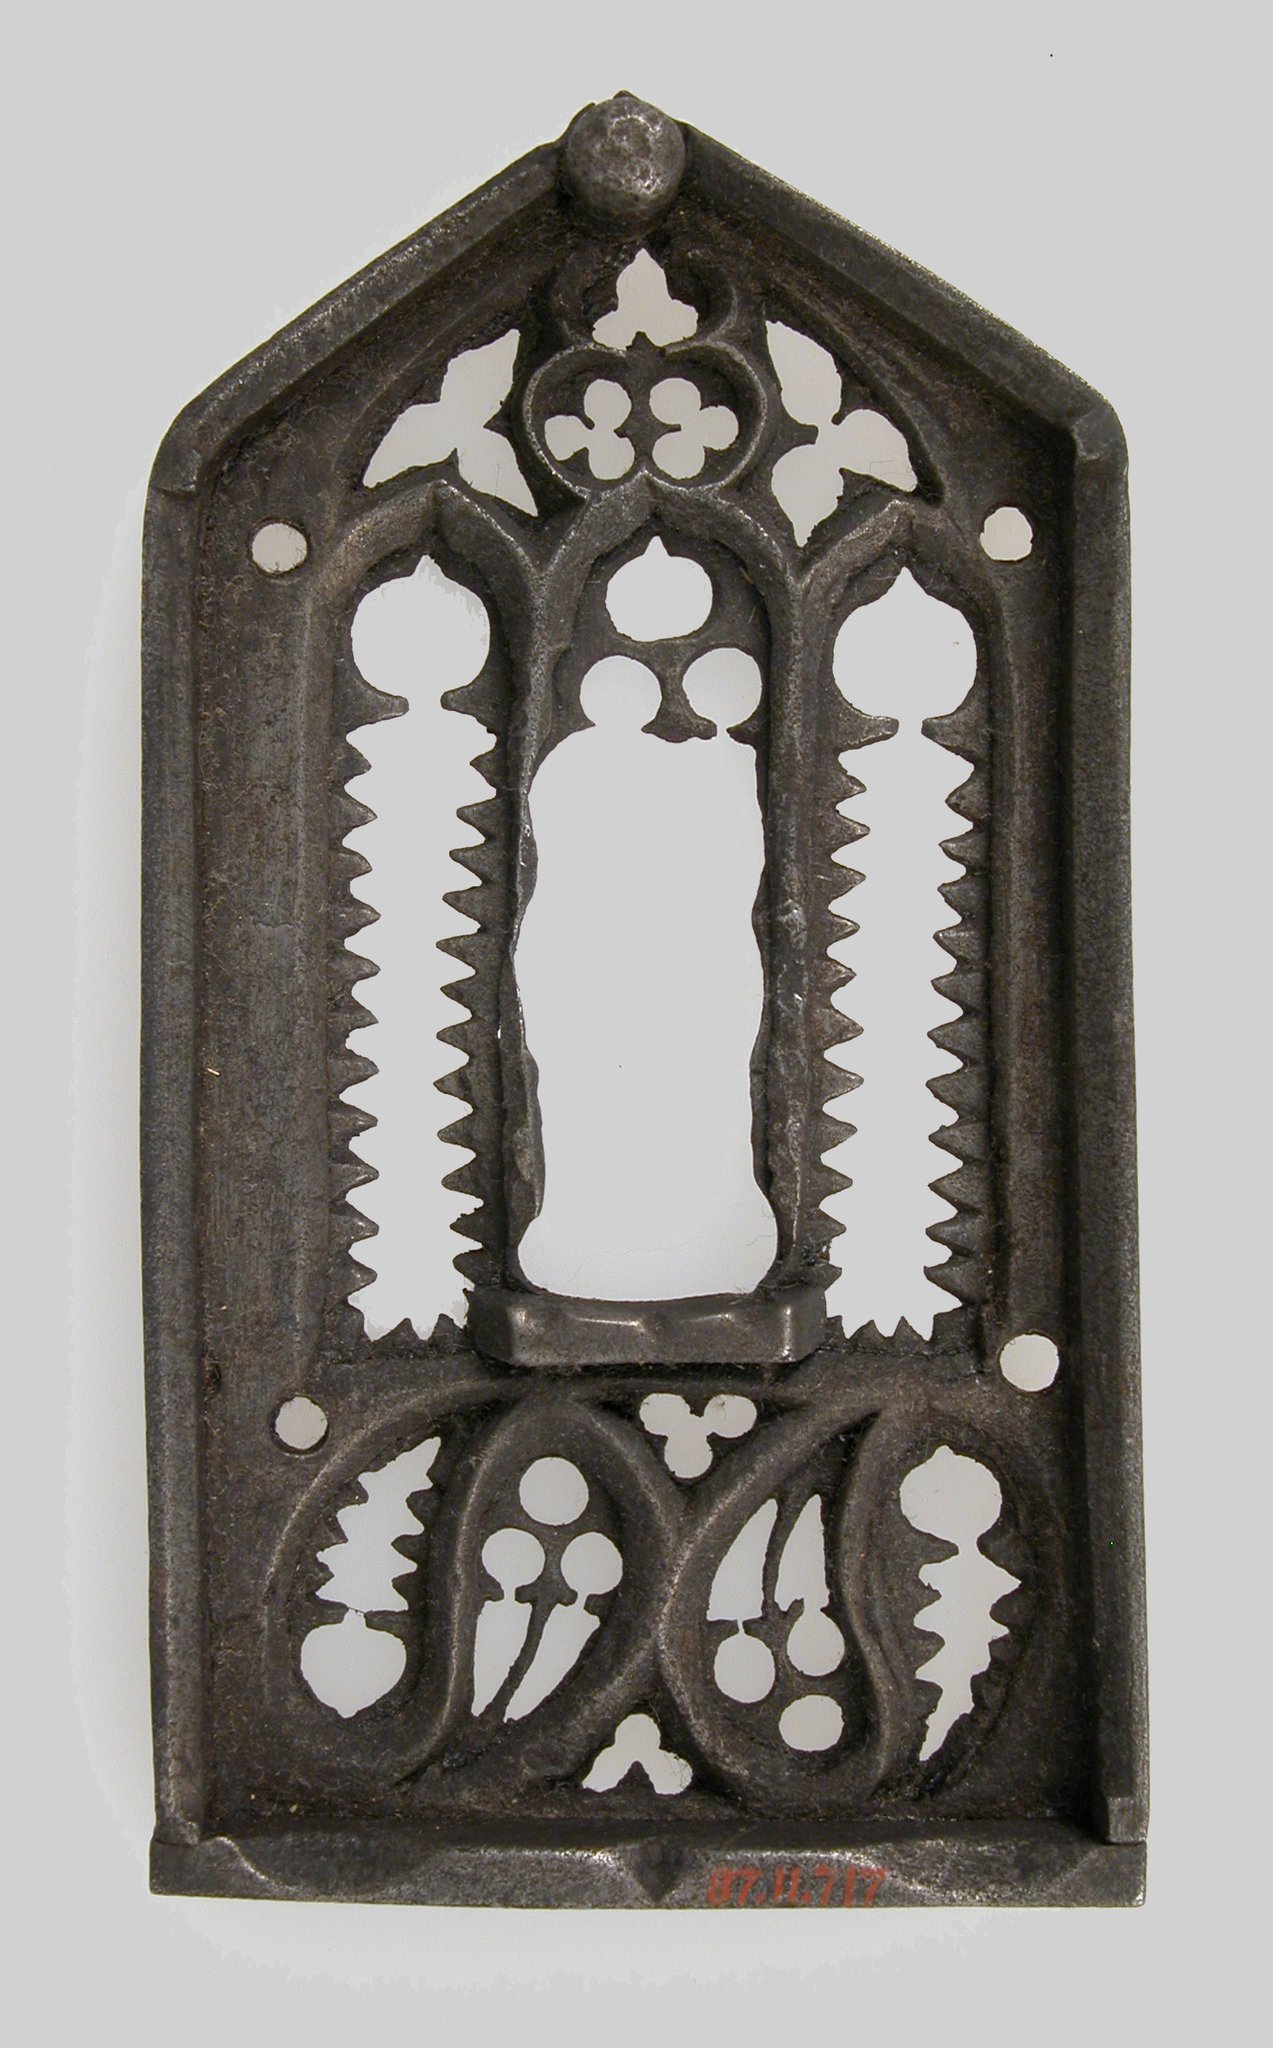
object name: escutcheon with lock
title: Escutcheon Plate of Lock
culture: german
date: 1401-1500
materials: iron